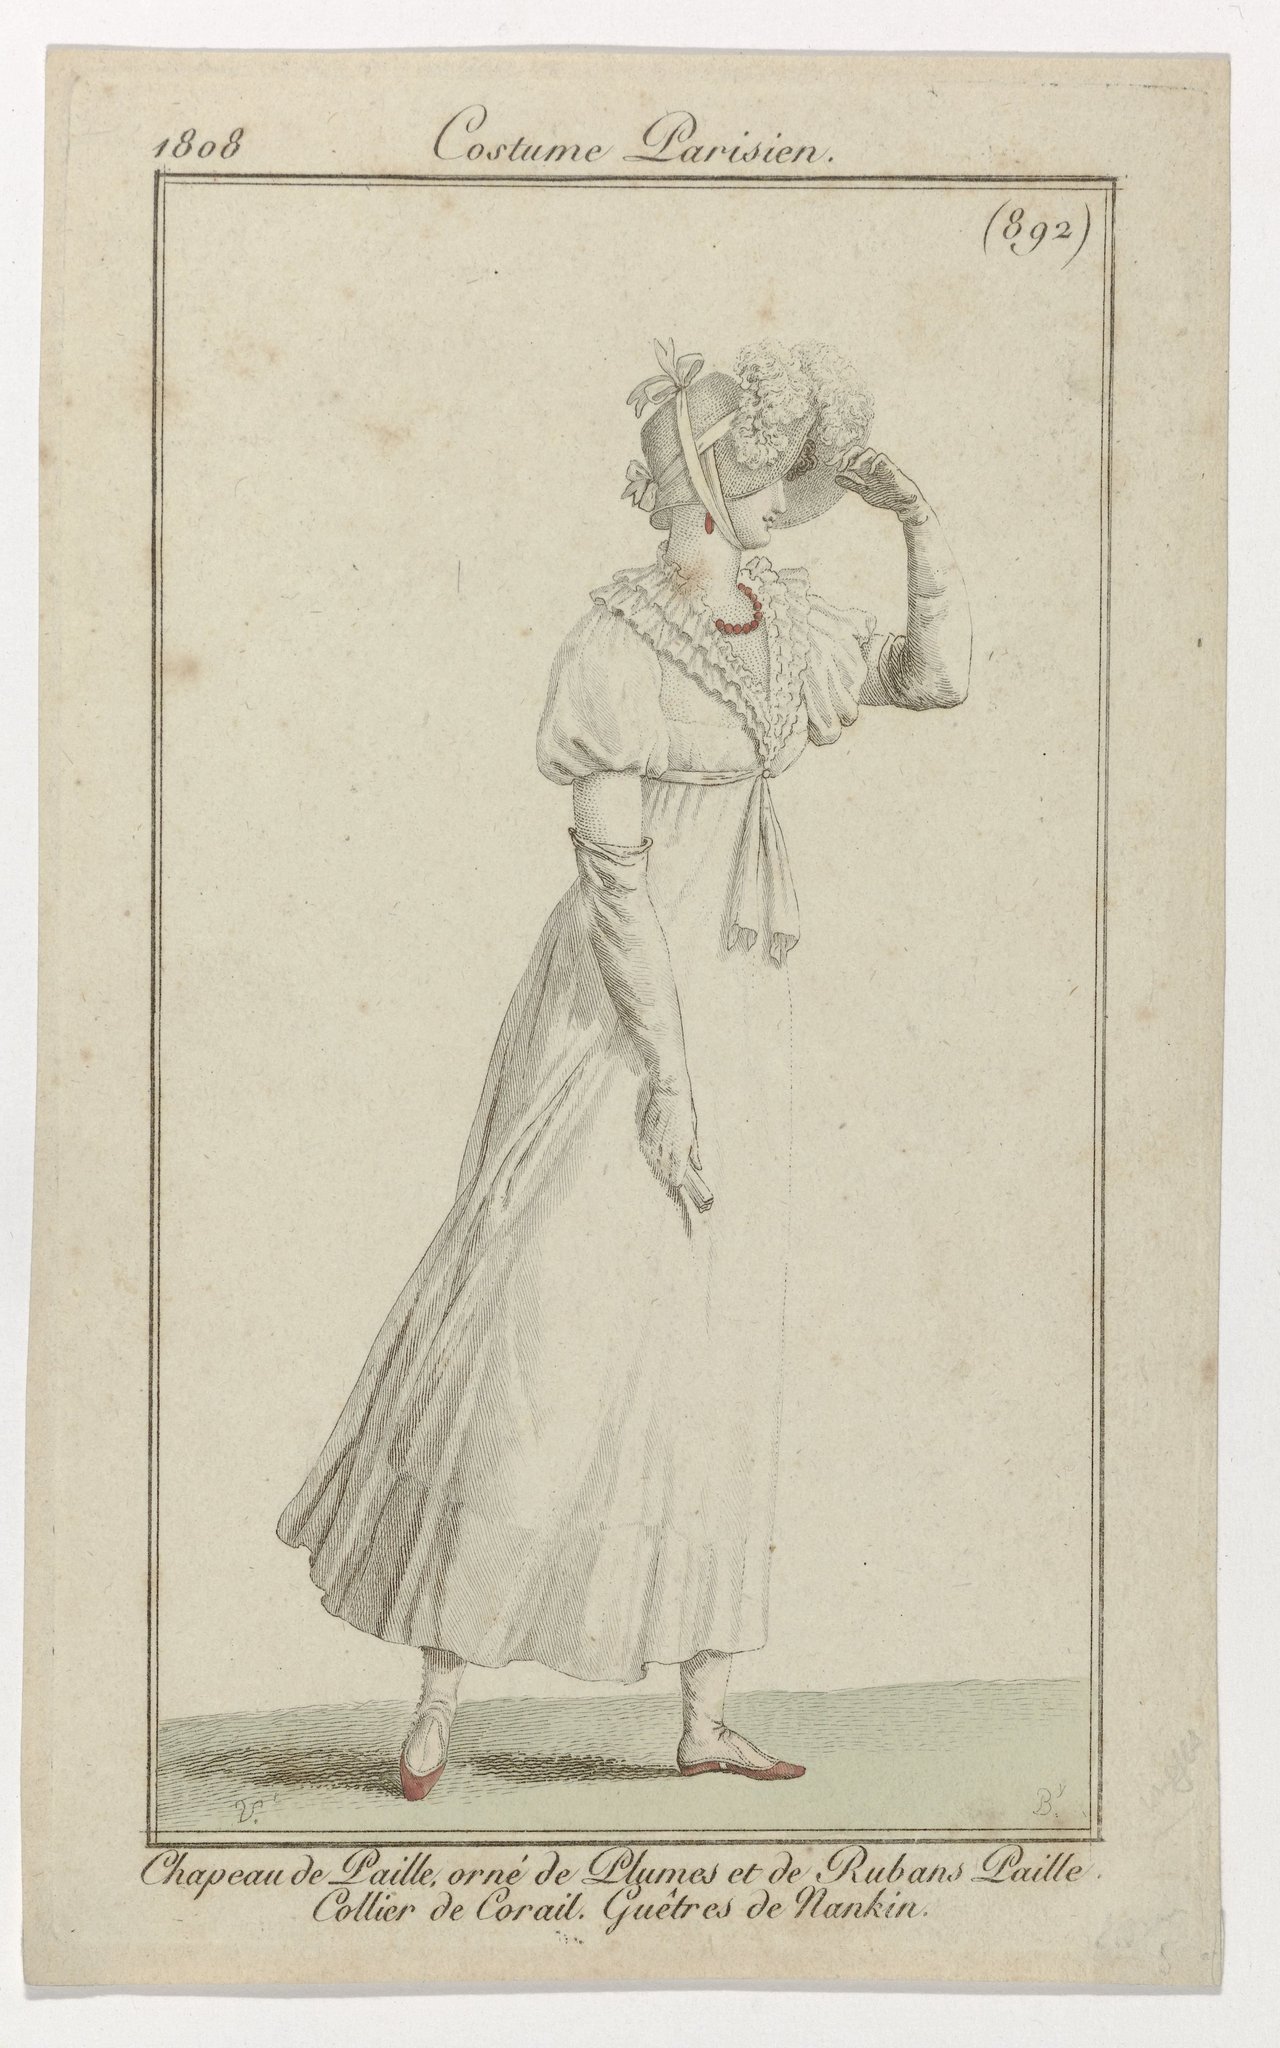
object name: fashion print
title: Journal des Dames et des Modes, Costume Parisien, 15 mai 1808, (892): Chapeau de Paill (...)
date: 1808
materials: paper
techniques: engraving, hand coloring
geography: paris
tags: ear-rings (+ women's clothes), gloves, mittens (long gloves) (+ women's clothes), head-gear (straw hat) (+ women's clothes), fashion plates, shoes, sandals (+ women's clothes), dress, gown (+ women's clothes), fan (+ women's clothes), necklace (+ women's clothes)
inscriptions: title: ‘Costume Parisien.’, caption: ‘Chapeau de Paille, orné de Plumes et de Rubans Paille. Collier de Corail. Guêtres de Nankin.’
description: Vrouw, lopend naar rechts, in een japon met korte pofmouwen, geplooide kraag en ceintuur. Op het hoofd een strohoed versierd met veren en linten van stro. Om de hals een collier van koraal. Slobkousen van 'nankin'. Verdere accessoires: oorbel in het rechteroor, lange handschoenen, waaier, platte schoenen. De prent maakt deel uit van het modetijdschrift Journal des Dames et des Modes, uitgegeven door Pierre de la Mésangère, Parijs, 1797-1839.